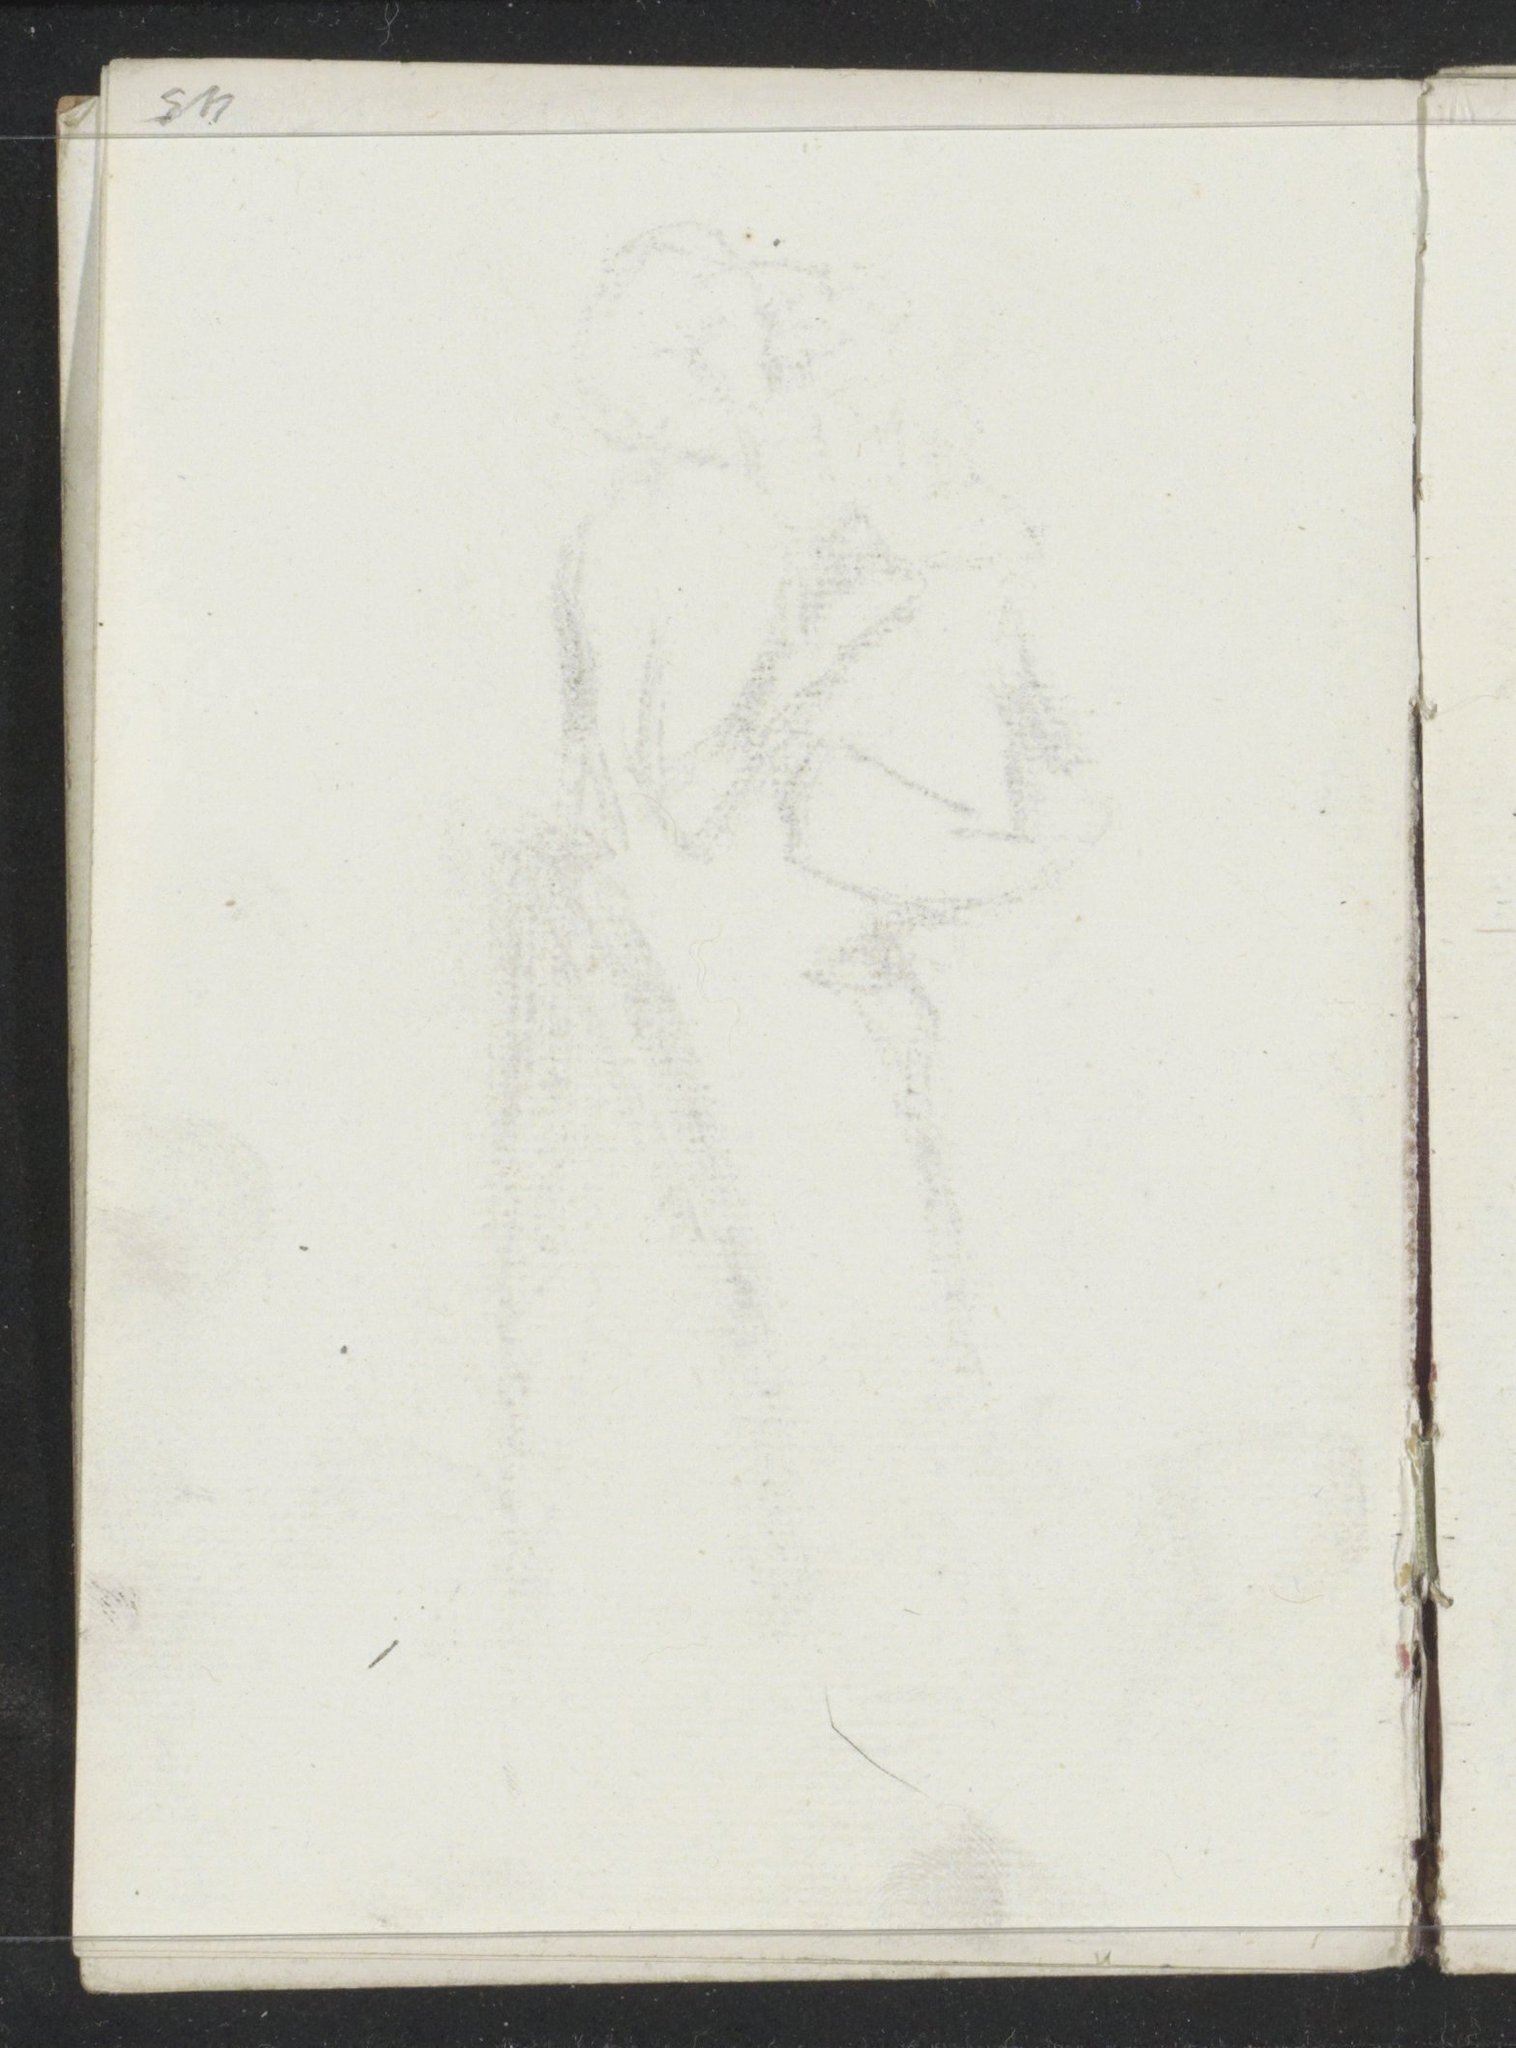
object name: sketchbook leaf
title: Abklatsch van de krijttekening op blad 3 recto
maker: isaac israels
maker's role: draughtsman, painter, print maker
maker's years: 1865-1934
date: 1886-1934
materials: paper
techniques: printmaking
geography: amsterdam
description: Blad 2 verso uit schetsboek LXIII met 23 bladen.